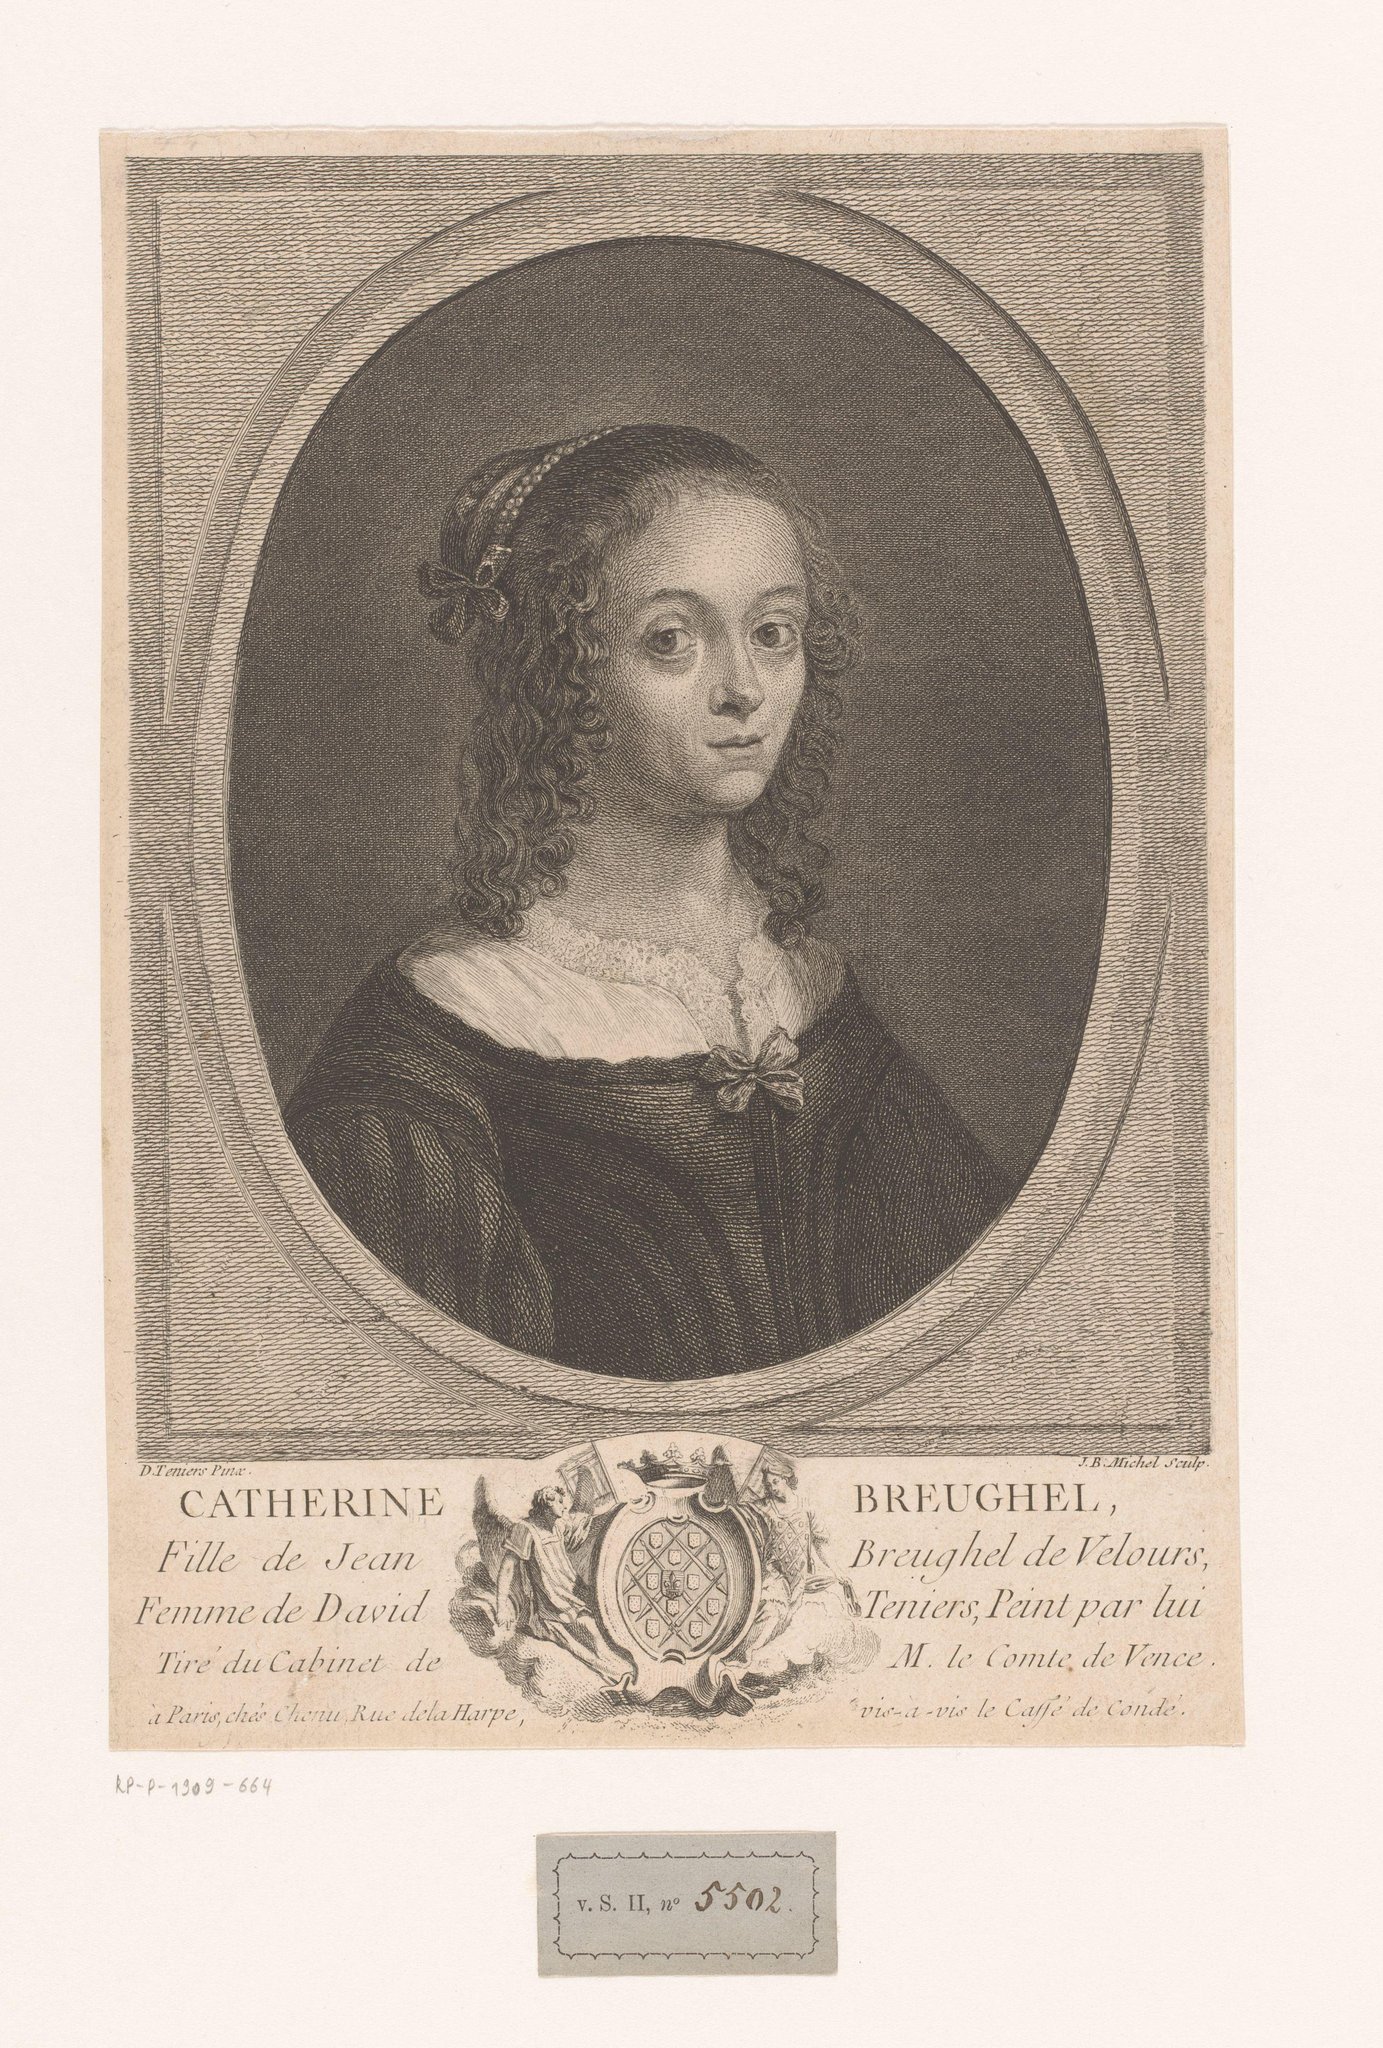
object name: print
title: Portret van Anna Brueghel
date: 1758-1804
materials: paper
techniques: engraving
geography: paris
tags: painter, historical persons - bb - woman, portrait, self-portrait of painter, armorial bearing, heraldry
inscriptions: collector's mark: Lugt 2228